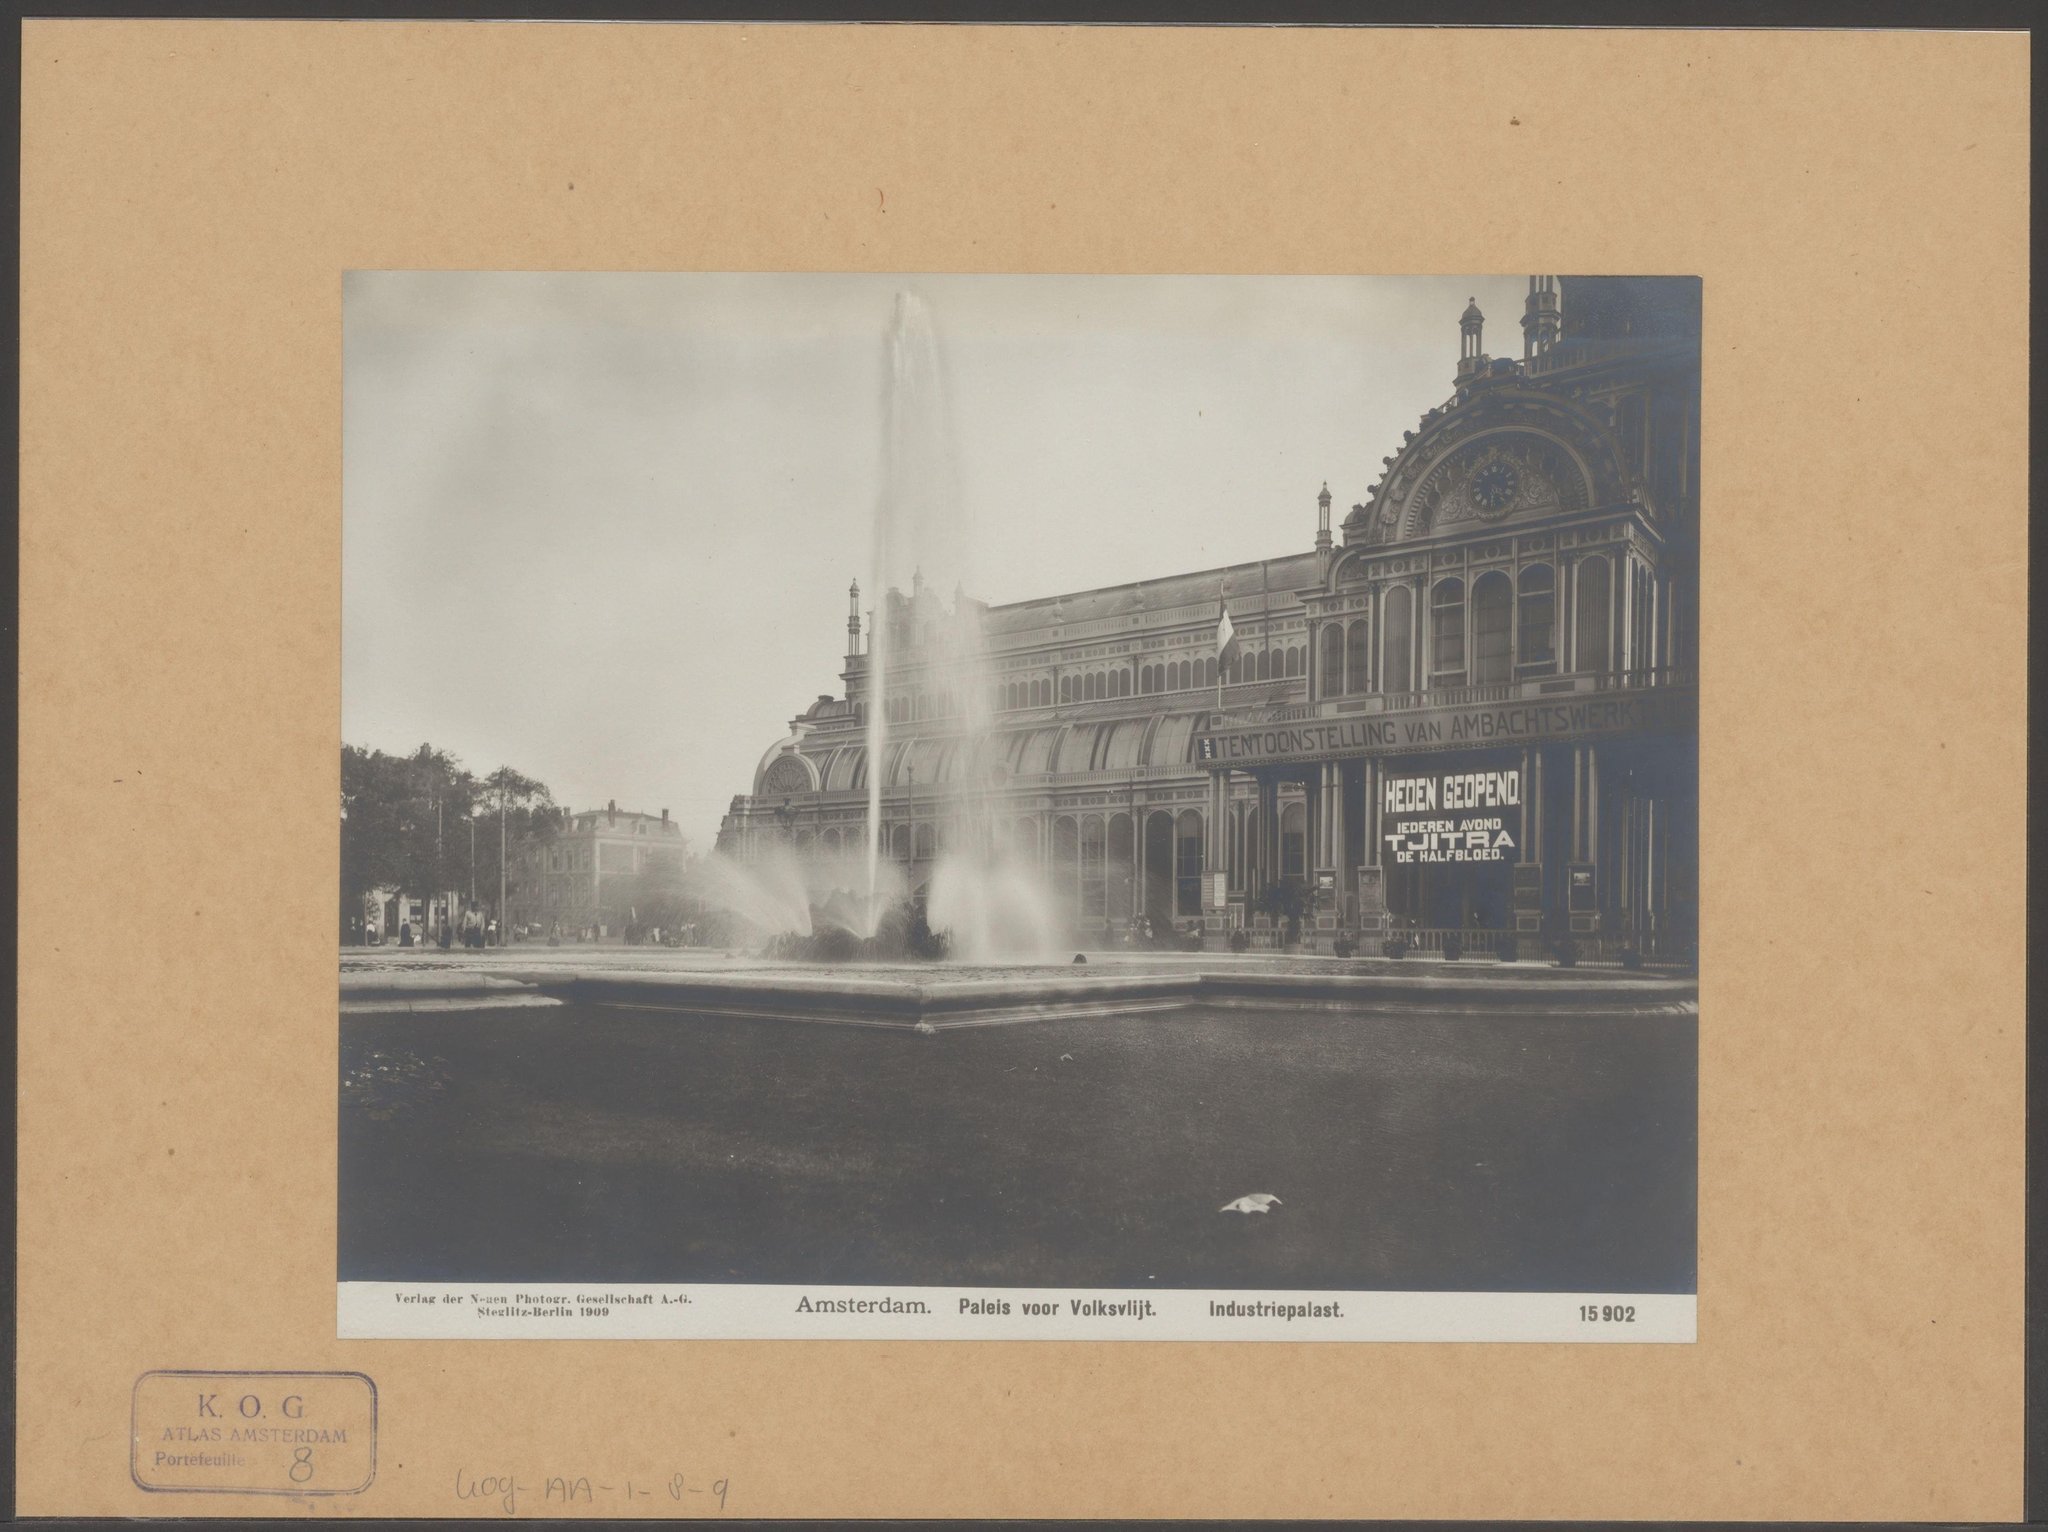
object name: photograph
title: Gezicht op het Paleis voor Volksvlijt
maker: Anonymous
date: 1909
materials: paper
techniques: gelatin silver print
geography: germany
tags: city-view in general; 'veduta', gallery (spacious corridor), exhibition ~ art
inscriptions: collector's mark: ‘8’ Lugt 1641b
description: Onderwerpsrubriek binnen de Atlas Amsterdam: Galerij Paleis voor Volksvlijt, Gebed zonder end, Geldersche Kade, Gravenstraat, Grimburgwal, Grimnessesluis, Groeneburgwal.